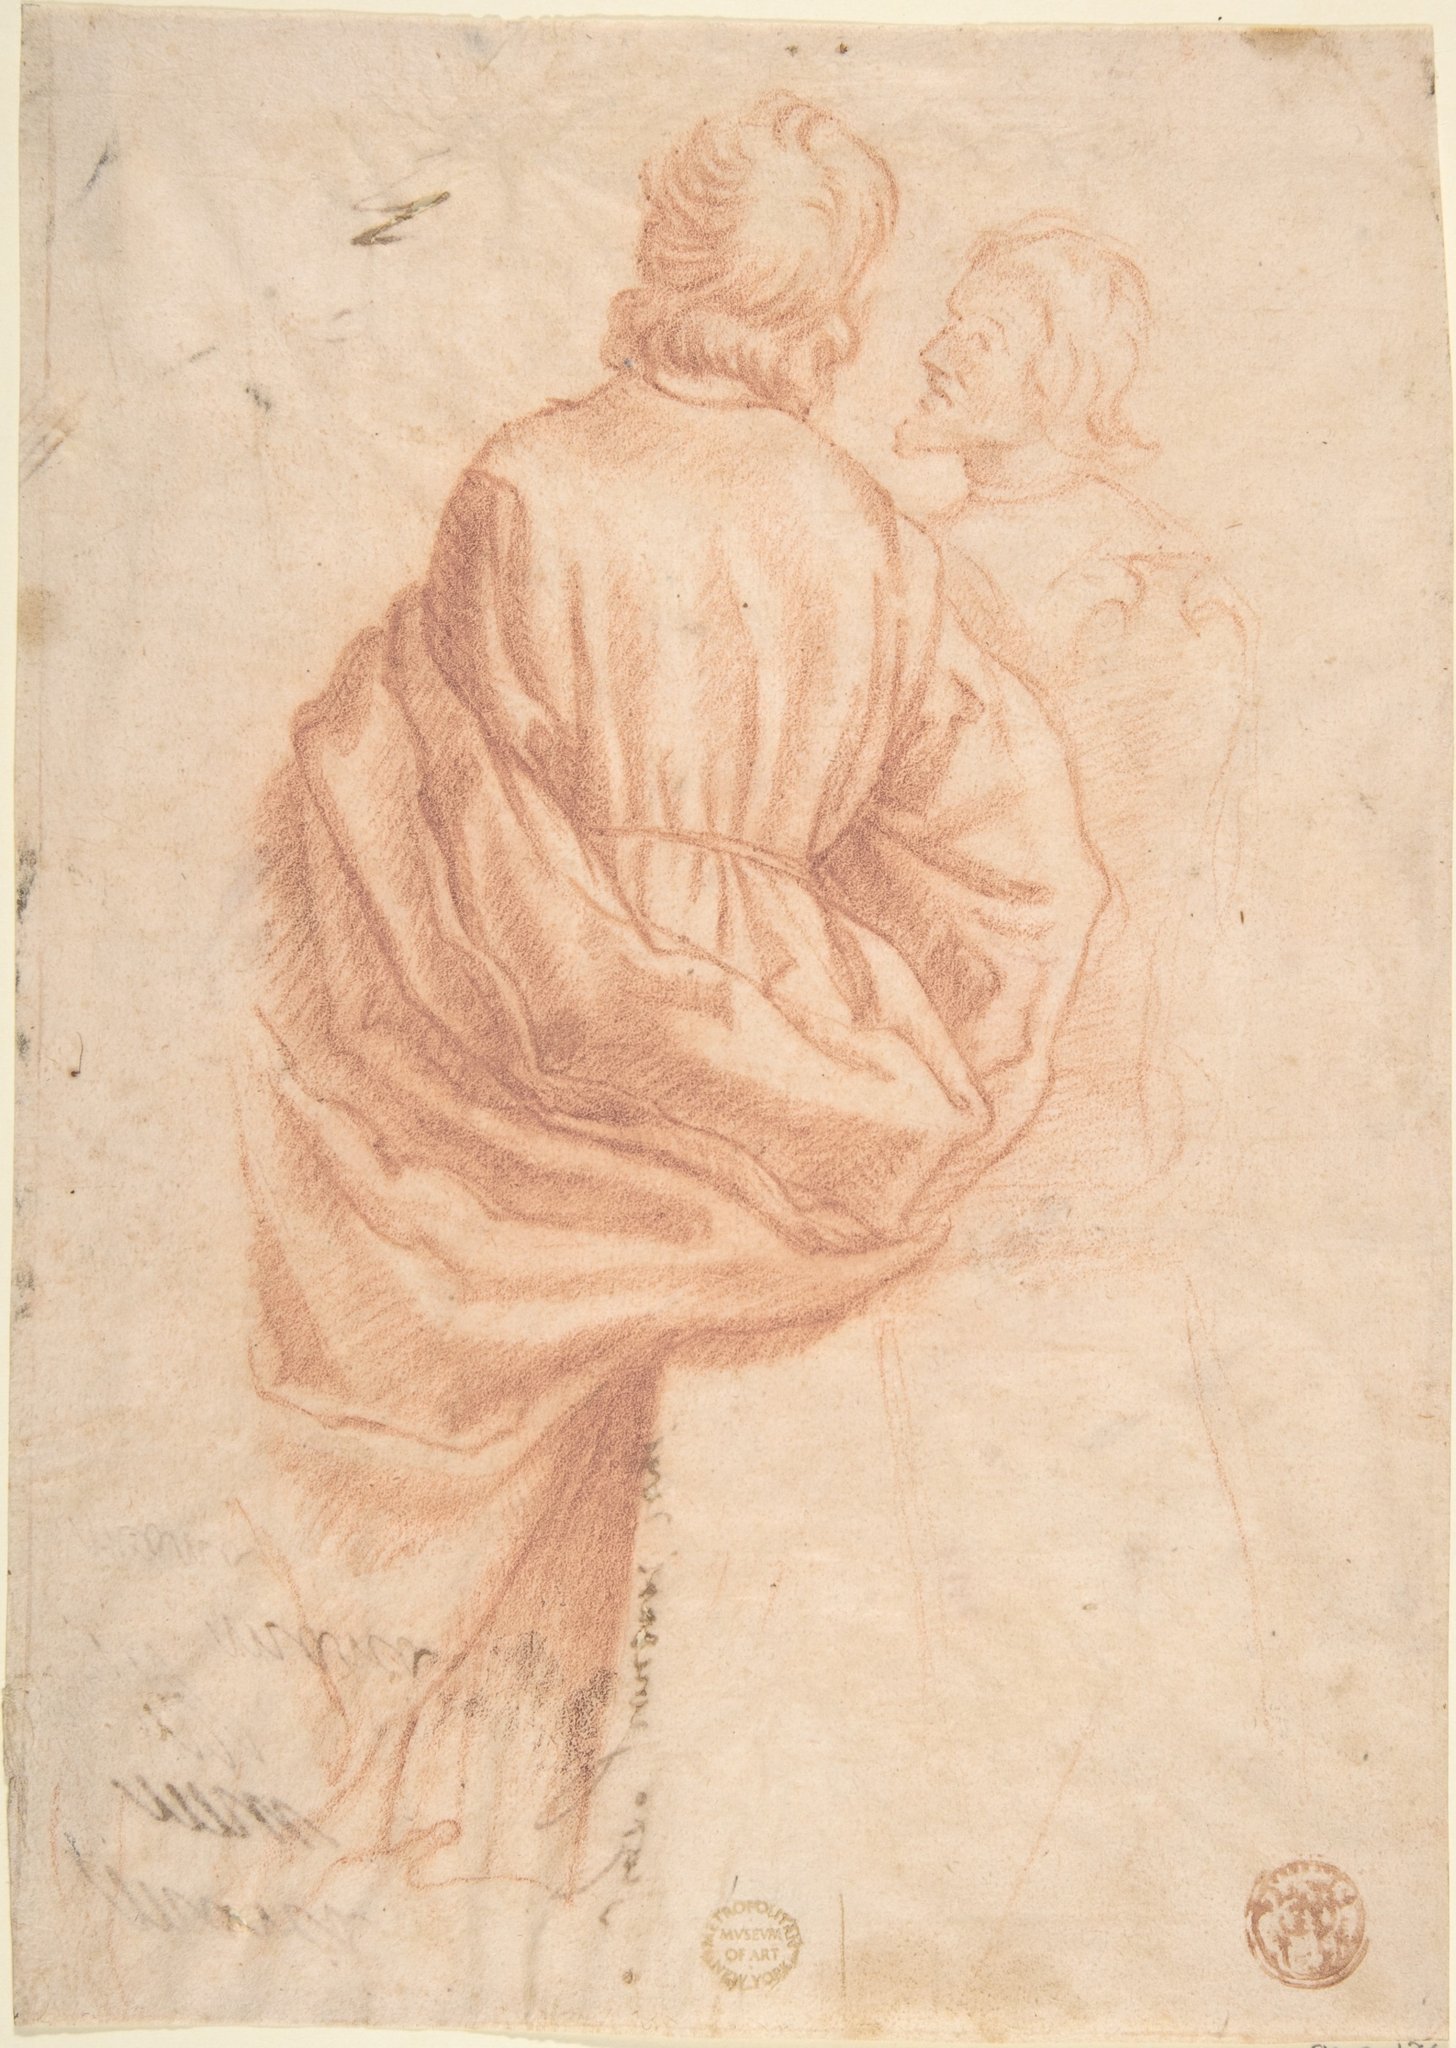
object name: drawing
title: Drapery Study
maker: anonymous, italian, florentine, second half of the 16th century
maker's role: artist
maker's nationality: italian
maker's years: 1550-1600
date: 1601-1700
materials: chalk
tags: men